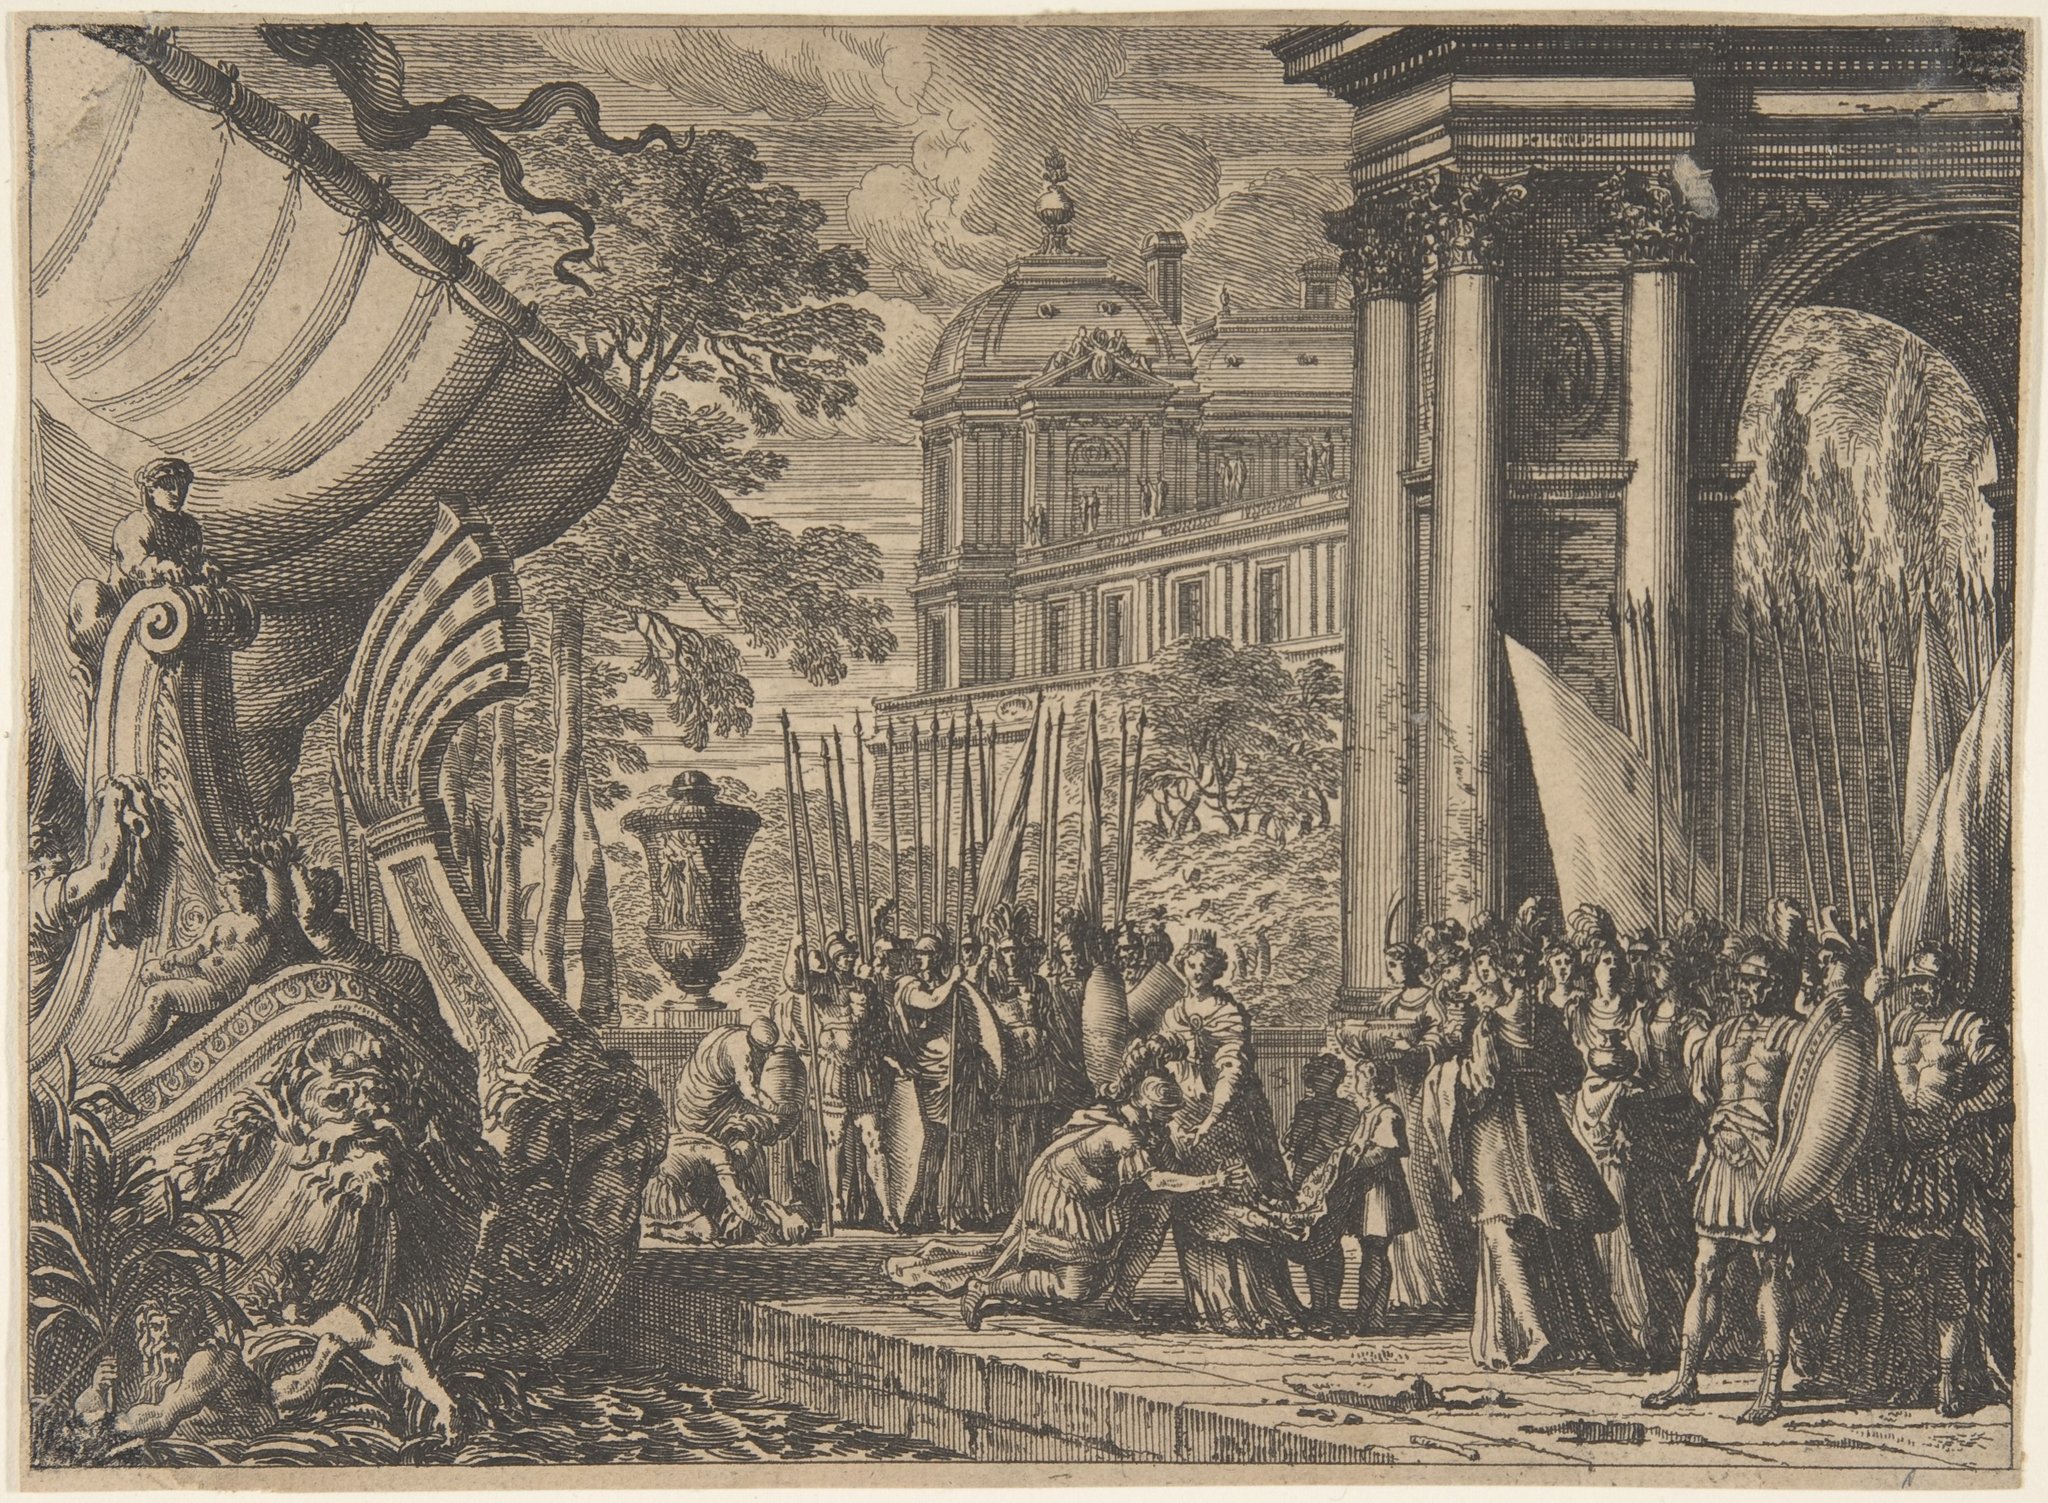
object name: print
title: Aeneas's Farewell to Dido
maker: jean le pautre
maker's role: artist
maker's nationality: french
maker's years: 1618-1682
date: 1618-1682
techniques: etching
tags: buildings,soldiers,spears,women,ships